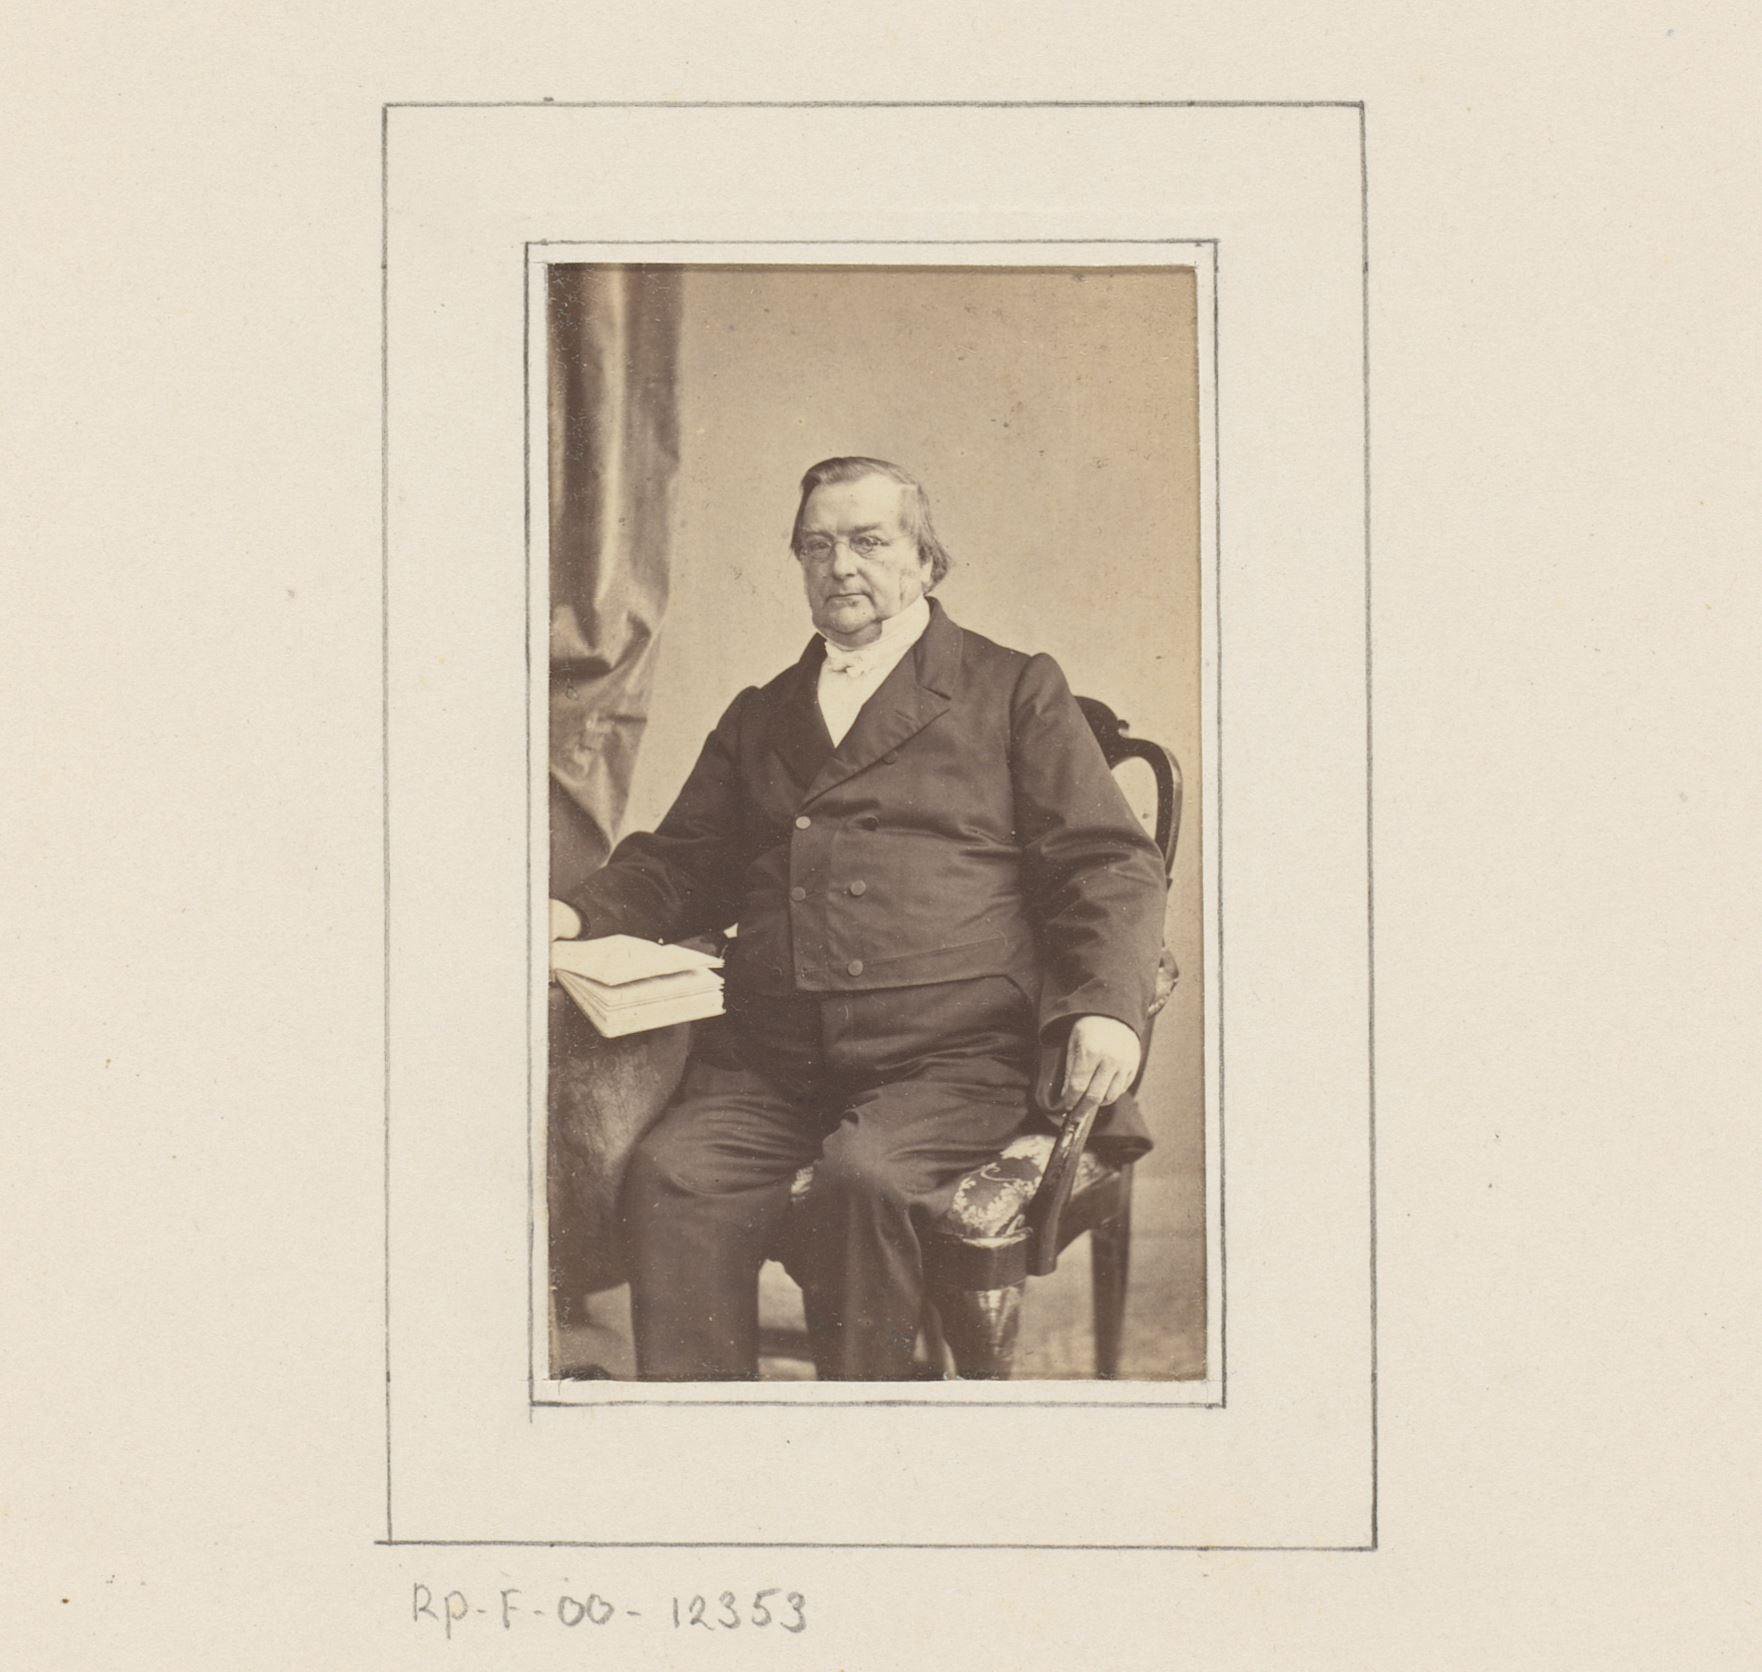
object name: reproduction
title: Fotoreproductie van een geschilderd portret van predikant Sybren Klases Sybrandi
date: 1862-1882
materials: cardboard, paper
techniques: albumen print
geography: haarlem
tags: historical persons, picture, painting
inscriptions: address: ‘CHs BINGER & Cie/ Zylstraat, HAARLEM.’